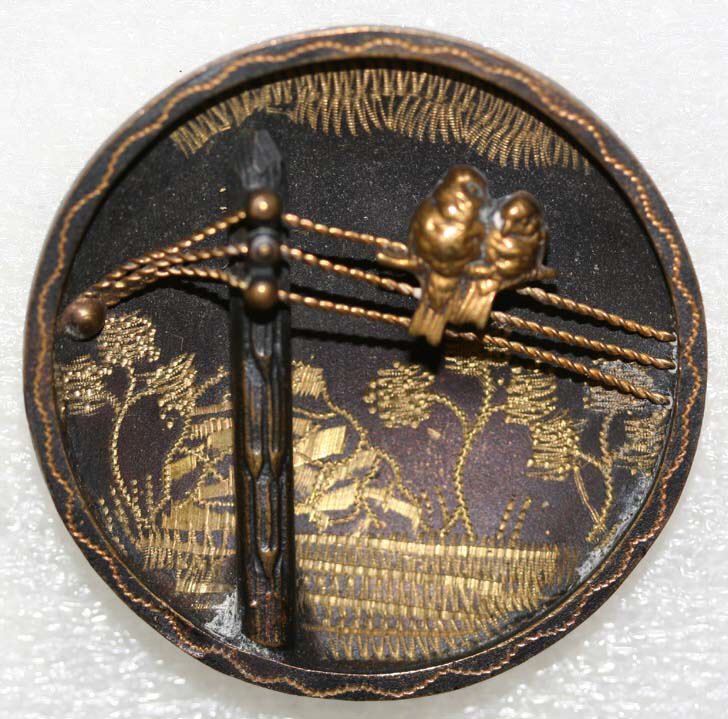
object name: button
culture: british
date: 1880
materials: metal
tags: birds